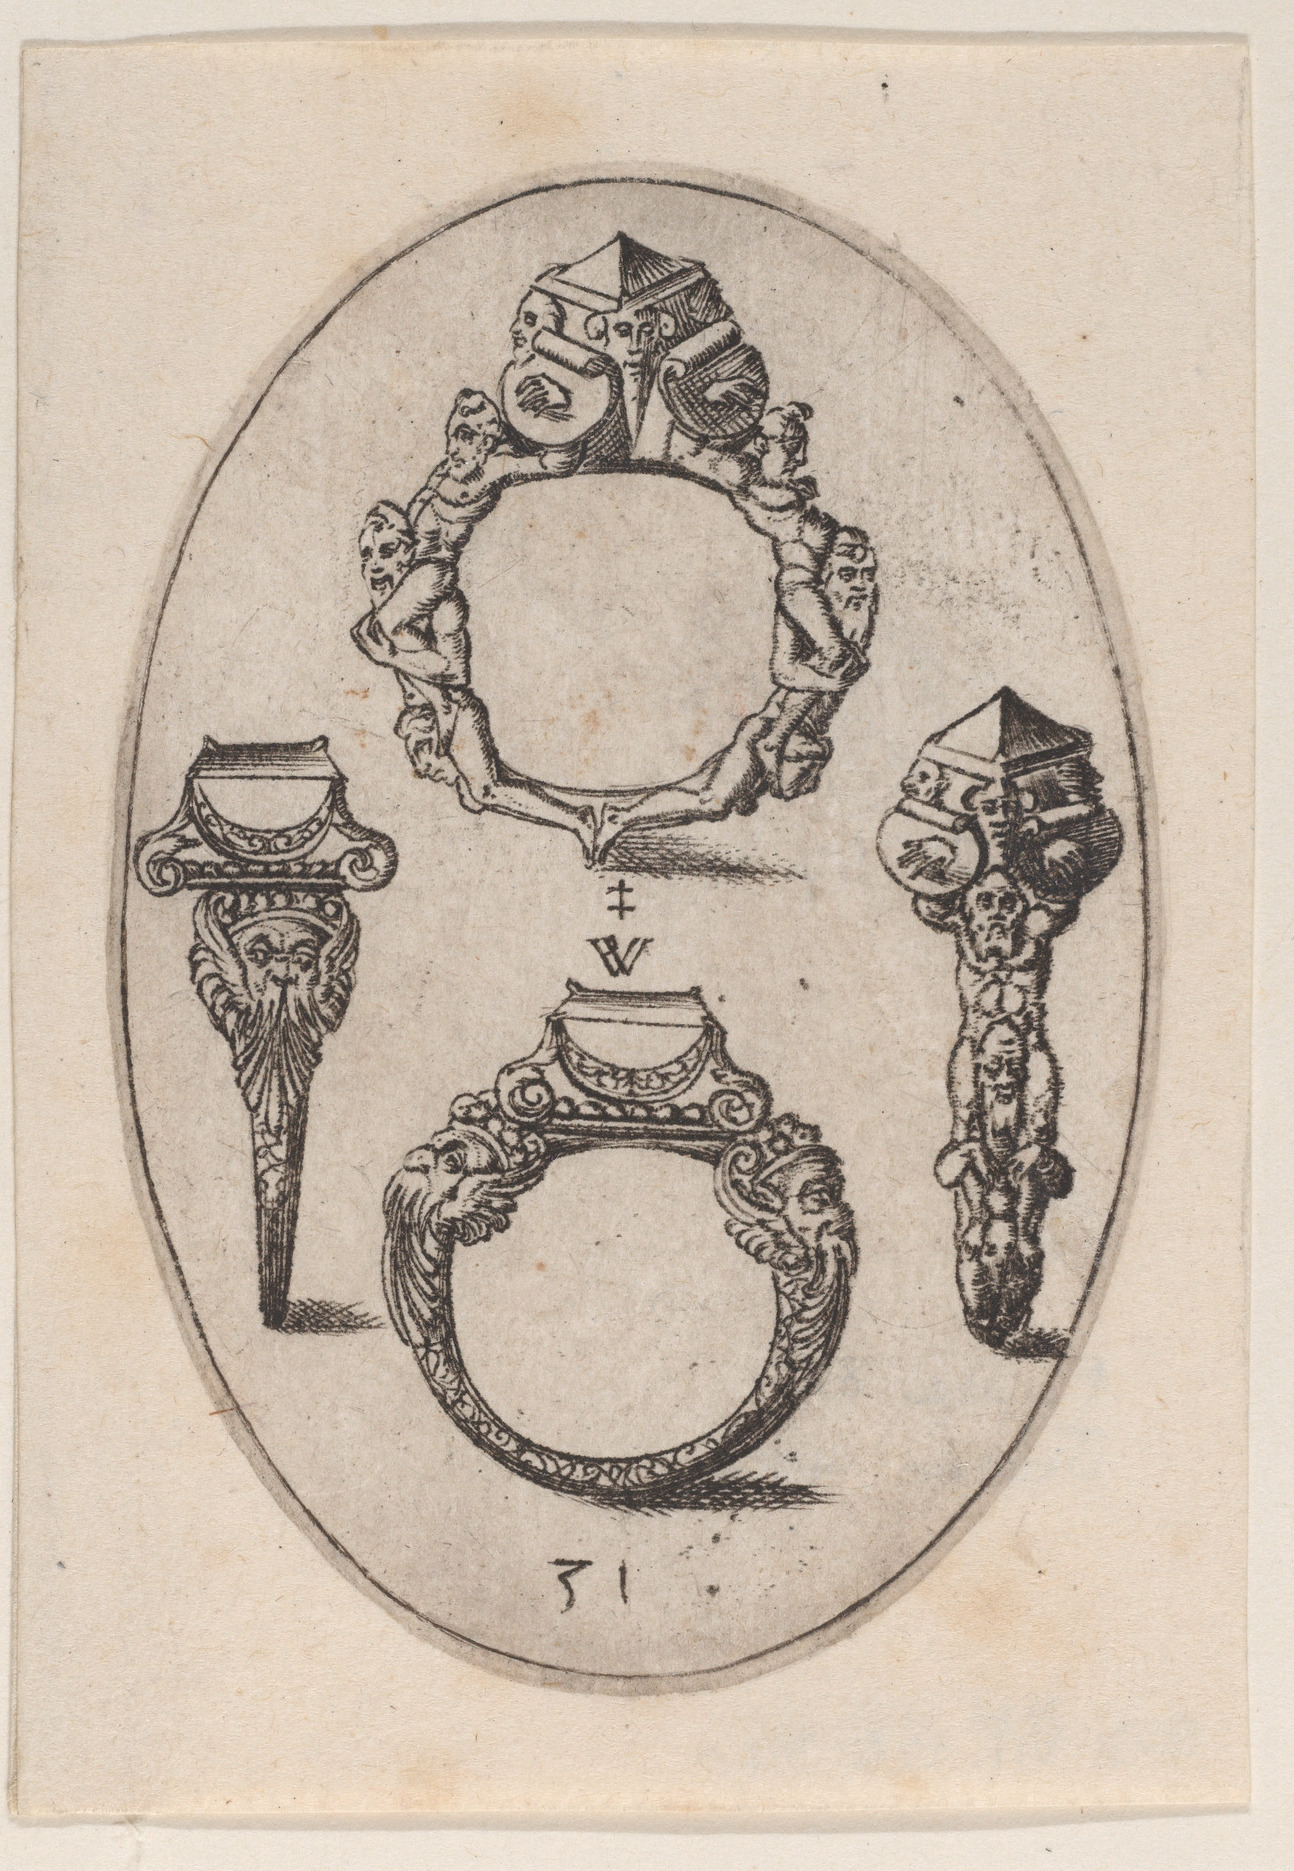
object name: print ornament architecture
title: Designs for Four Rings, Plate 31 from 'Livre d'Aneaux d'Orfevrerie'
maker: pierre woeiriot de bouzey ii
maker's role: artist and engraver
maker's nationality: french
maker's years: 1532-1599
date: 1561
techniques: engraving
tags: rings